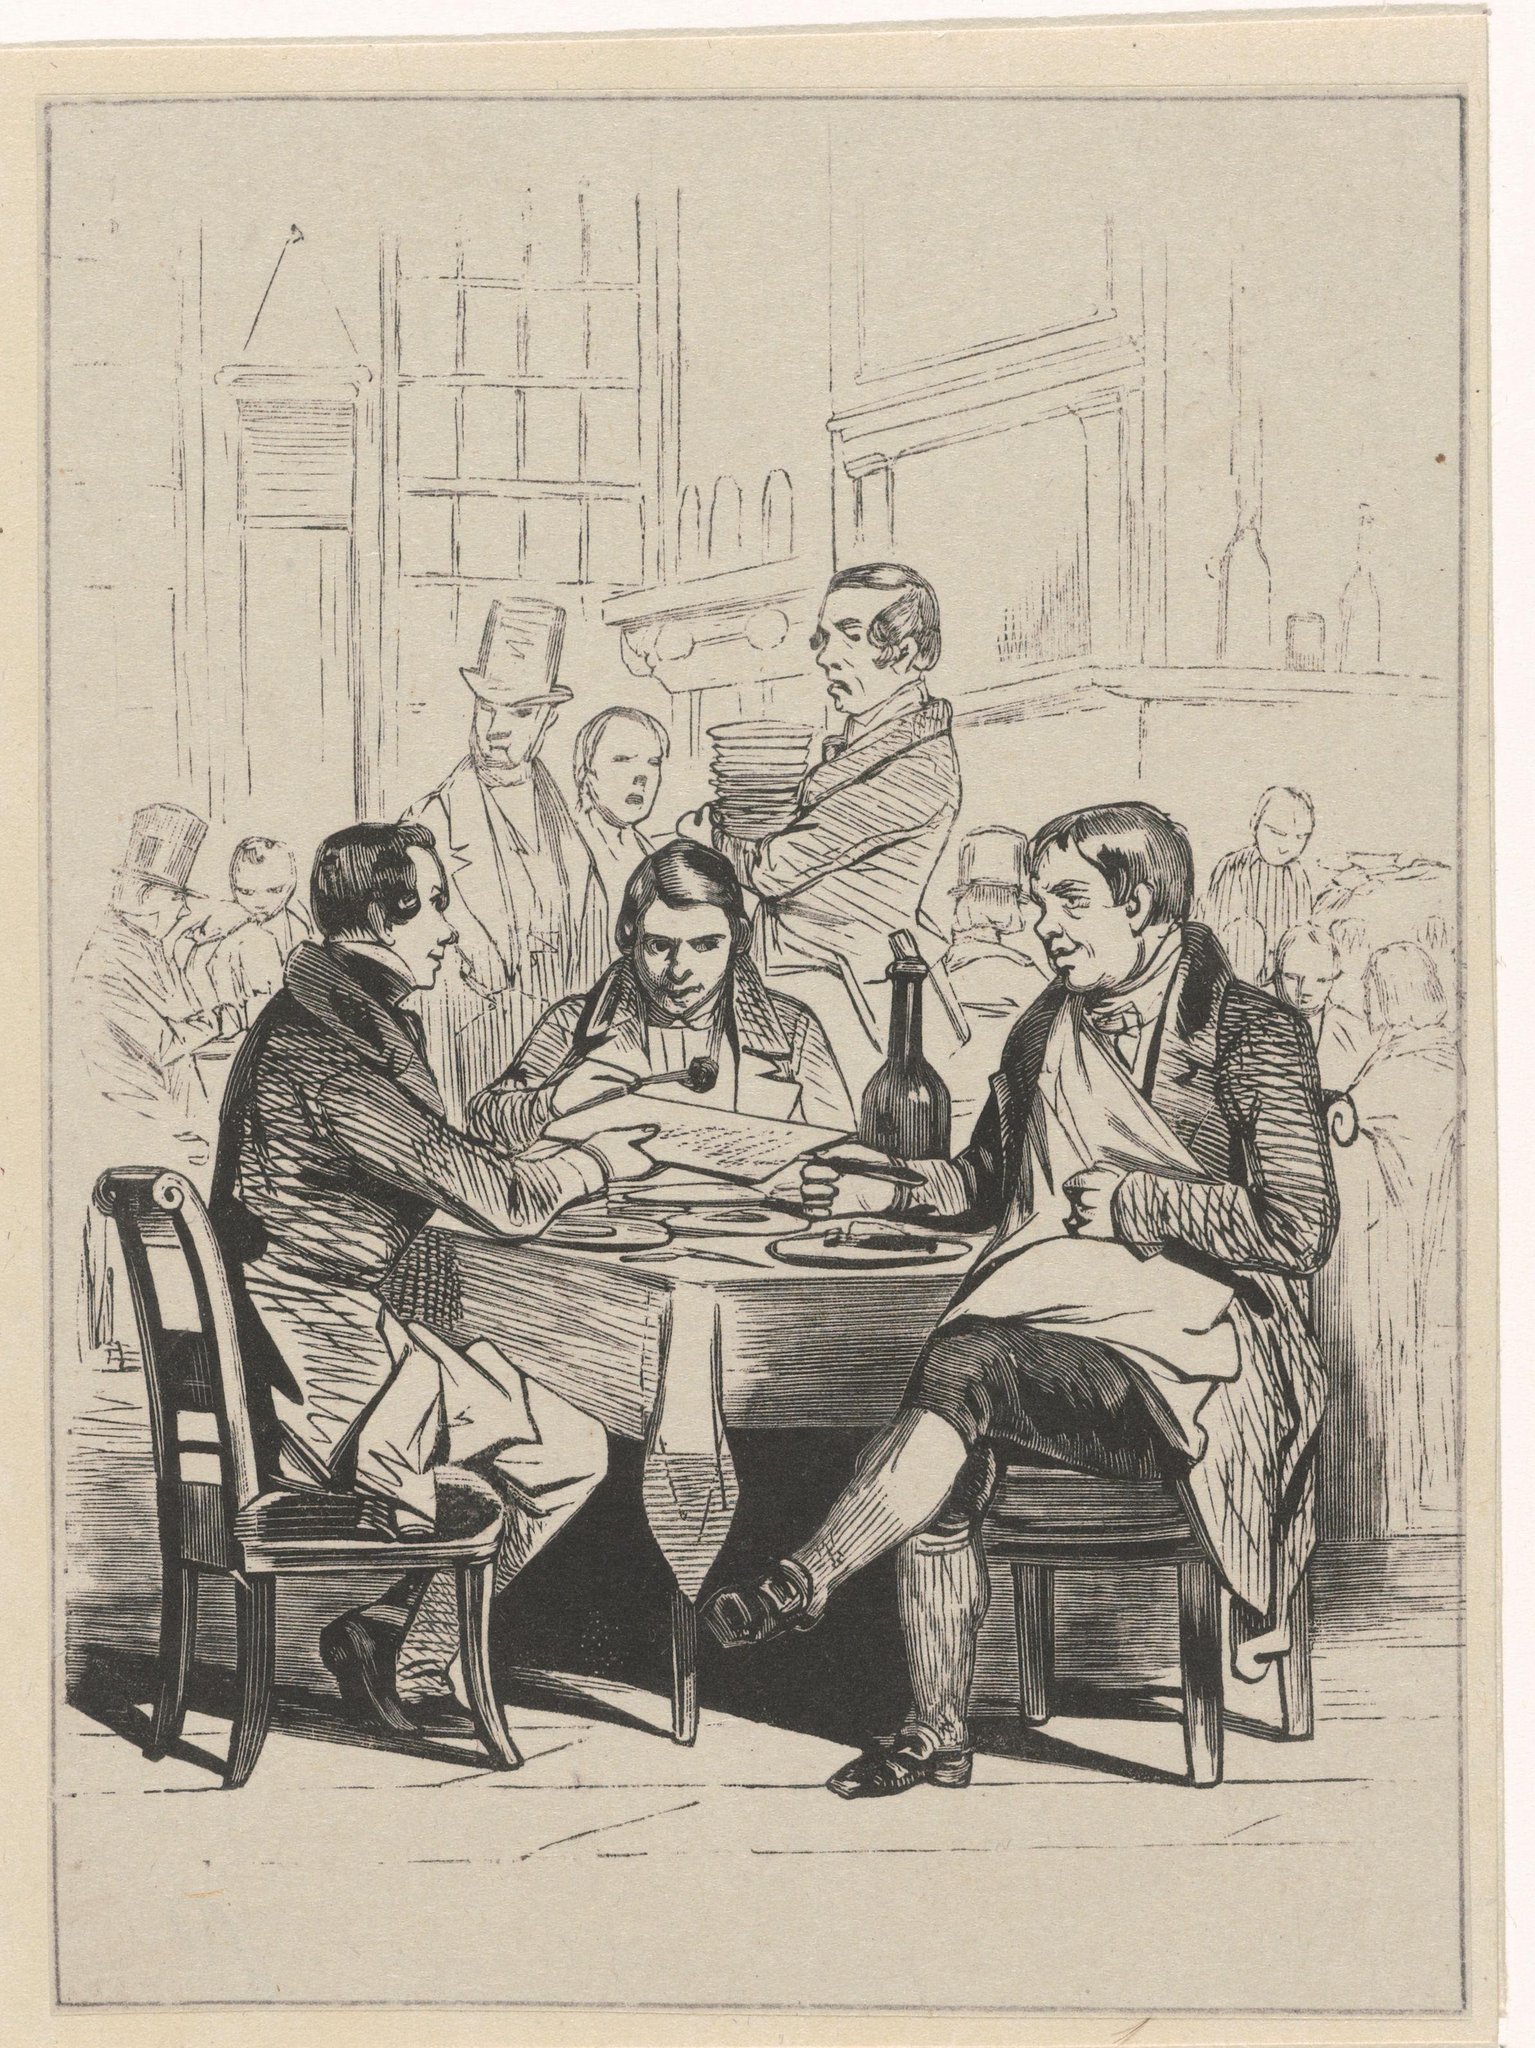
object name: print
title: Drie mannen aan een tafel in een restaurant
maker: elchanon verveer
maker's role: draughtsman, print maker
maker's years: 1826-1900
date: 1836-1900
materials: paper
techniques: engraving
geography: the hague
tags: restaurant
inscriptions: collector's mark: Lugt 2228